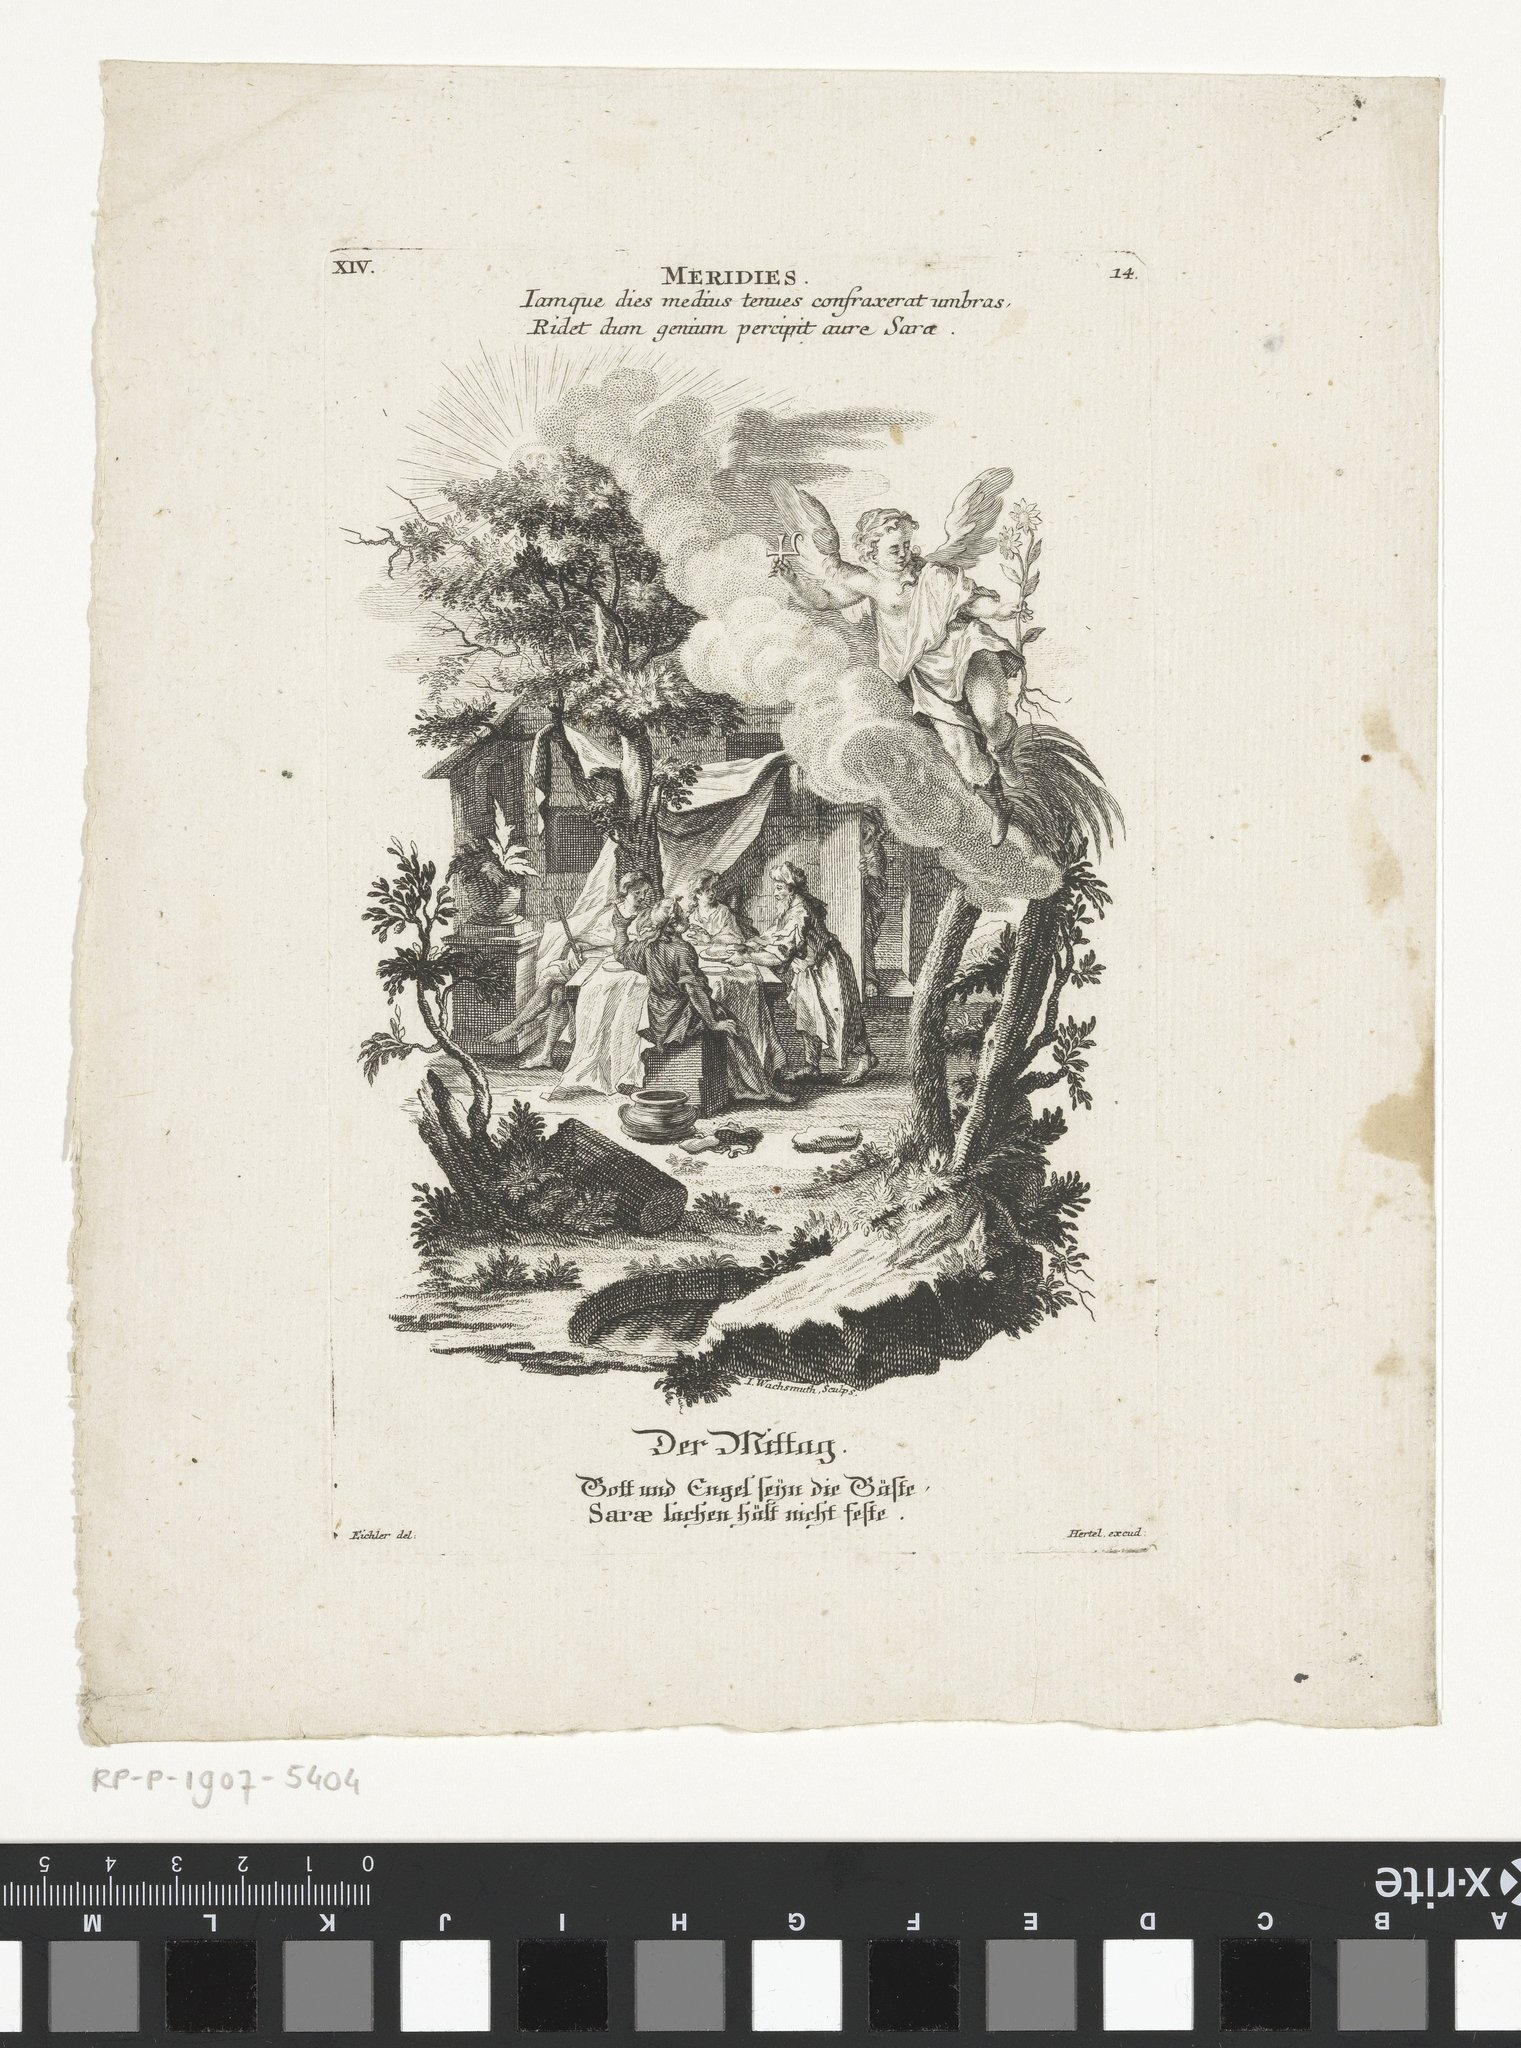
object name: print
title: De middag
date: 1758-1760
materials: paper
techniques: etching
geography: augsburg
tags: abraham entertaining the three angels, personification of the afternoon, 'meridies'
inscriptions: collector's mark: Lugt 2228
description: Boven zweeft de gevleugelde personificatie van de Middag op een wolk. In zijn rechterhand heeft hij het symbool voor de planeet Jupiter en in zijn linkerhand twee lotusbloemen, symbool voor het middaguur. Op de achtergrond zit Abraham met de drie engelen aan het middagmaal waar de geboorte van Isaak aangekondigd wordt. Sara luistert stiekem mee. Boven een drieregelige tekst in het Latijn en onder een drieregelige tekst in het Duits.